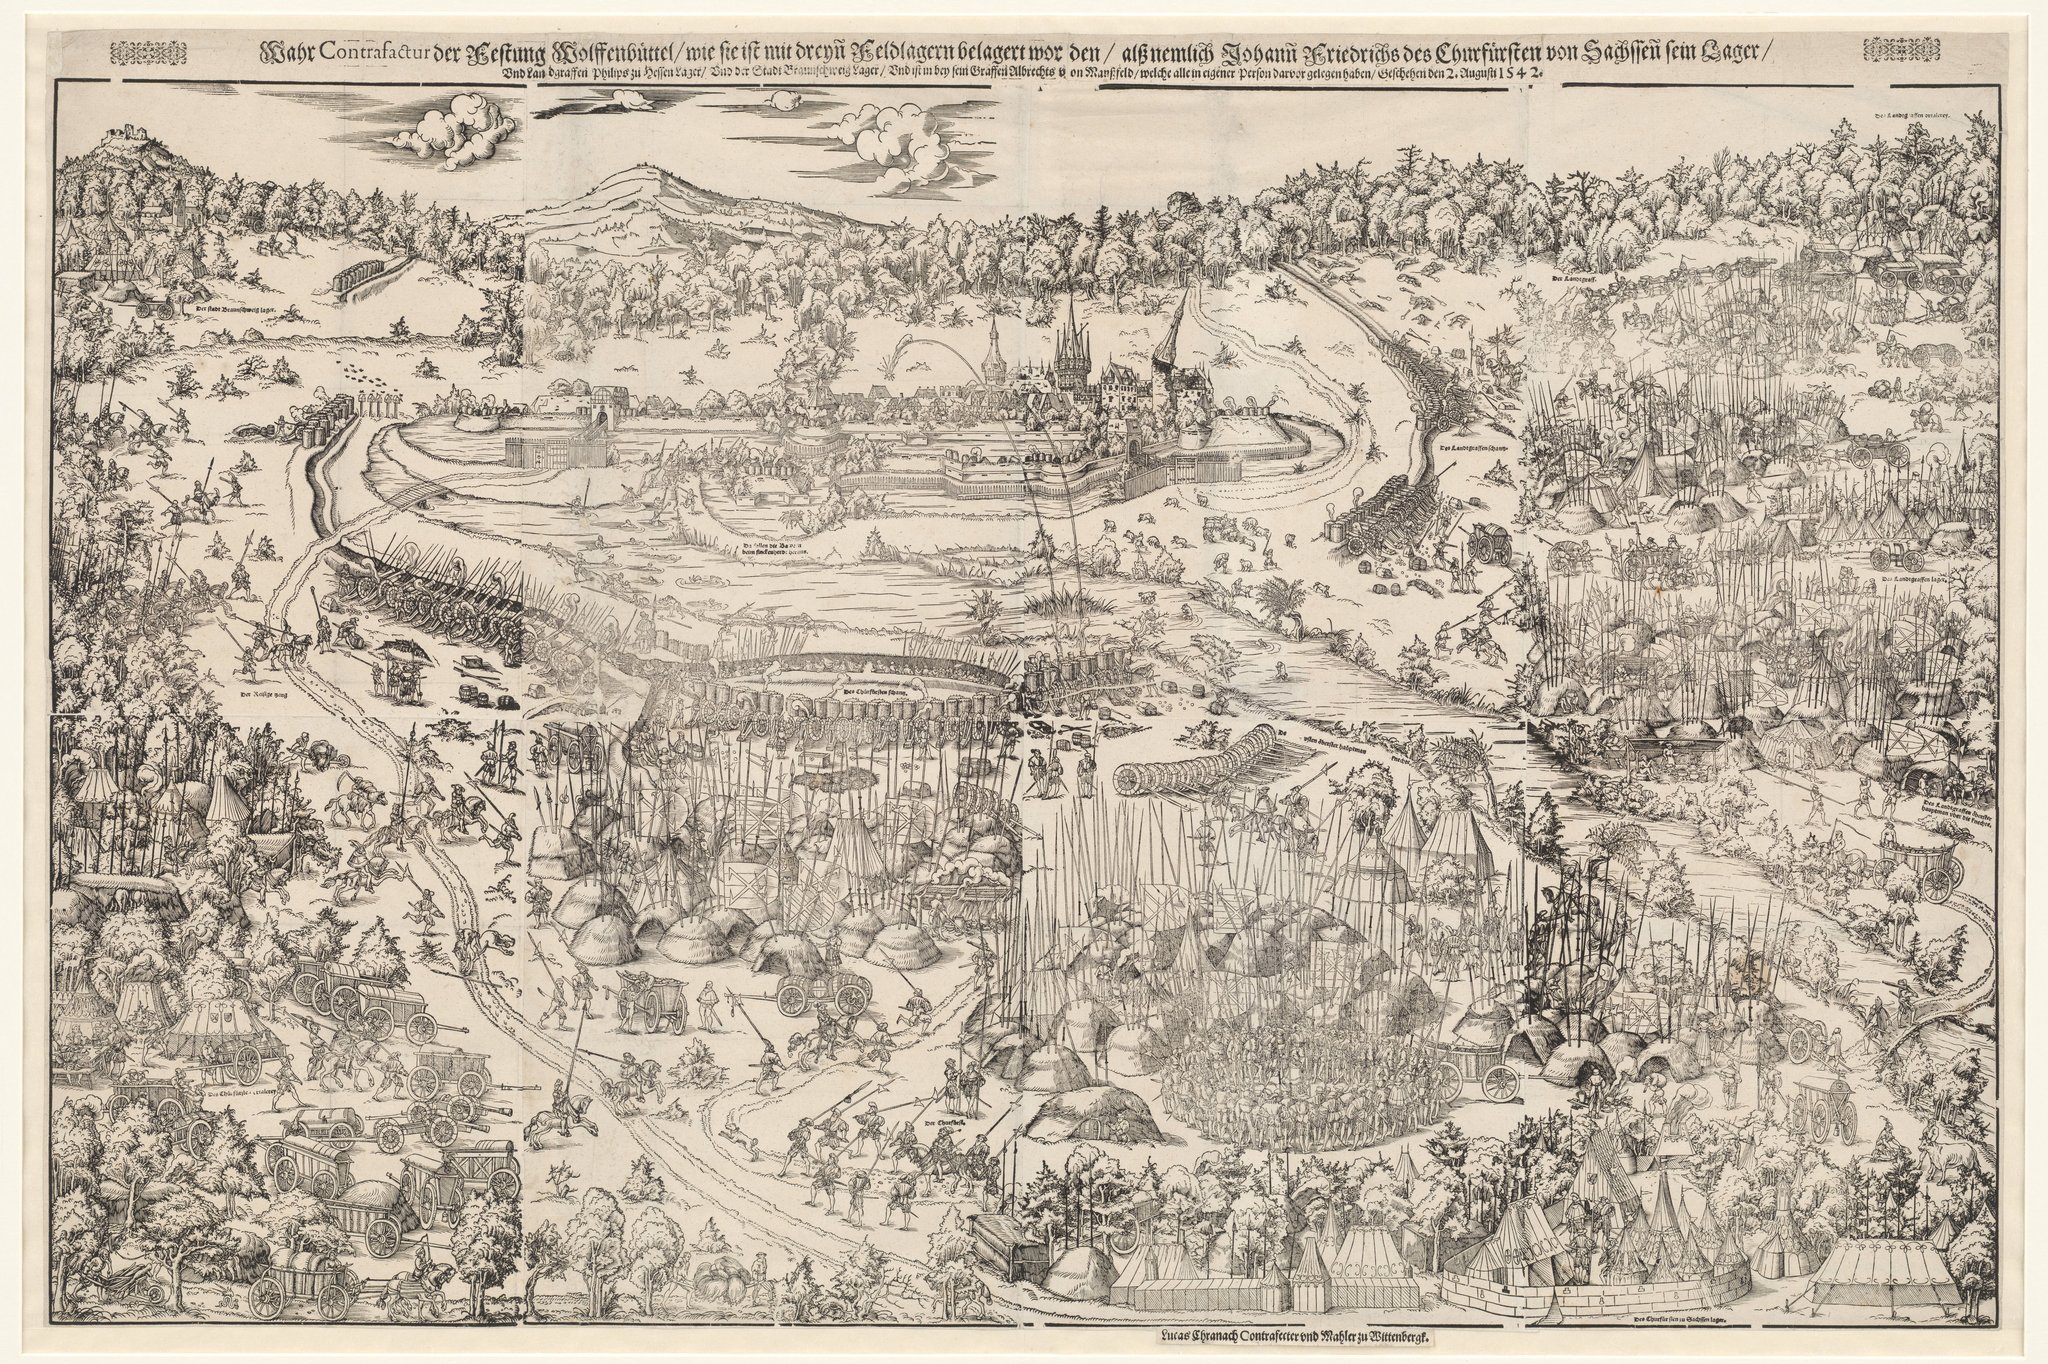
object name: print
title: Het beleg van Wolffenbüttel, 1542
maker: Anonymous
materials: paper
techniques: woodcut